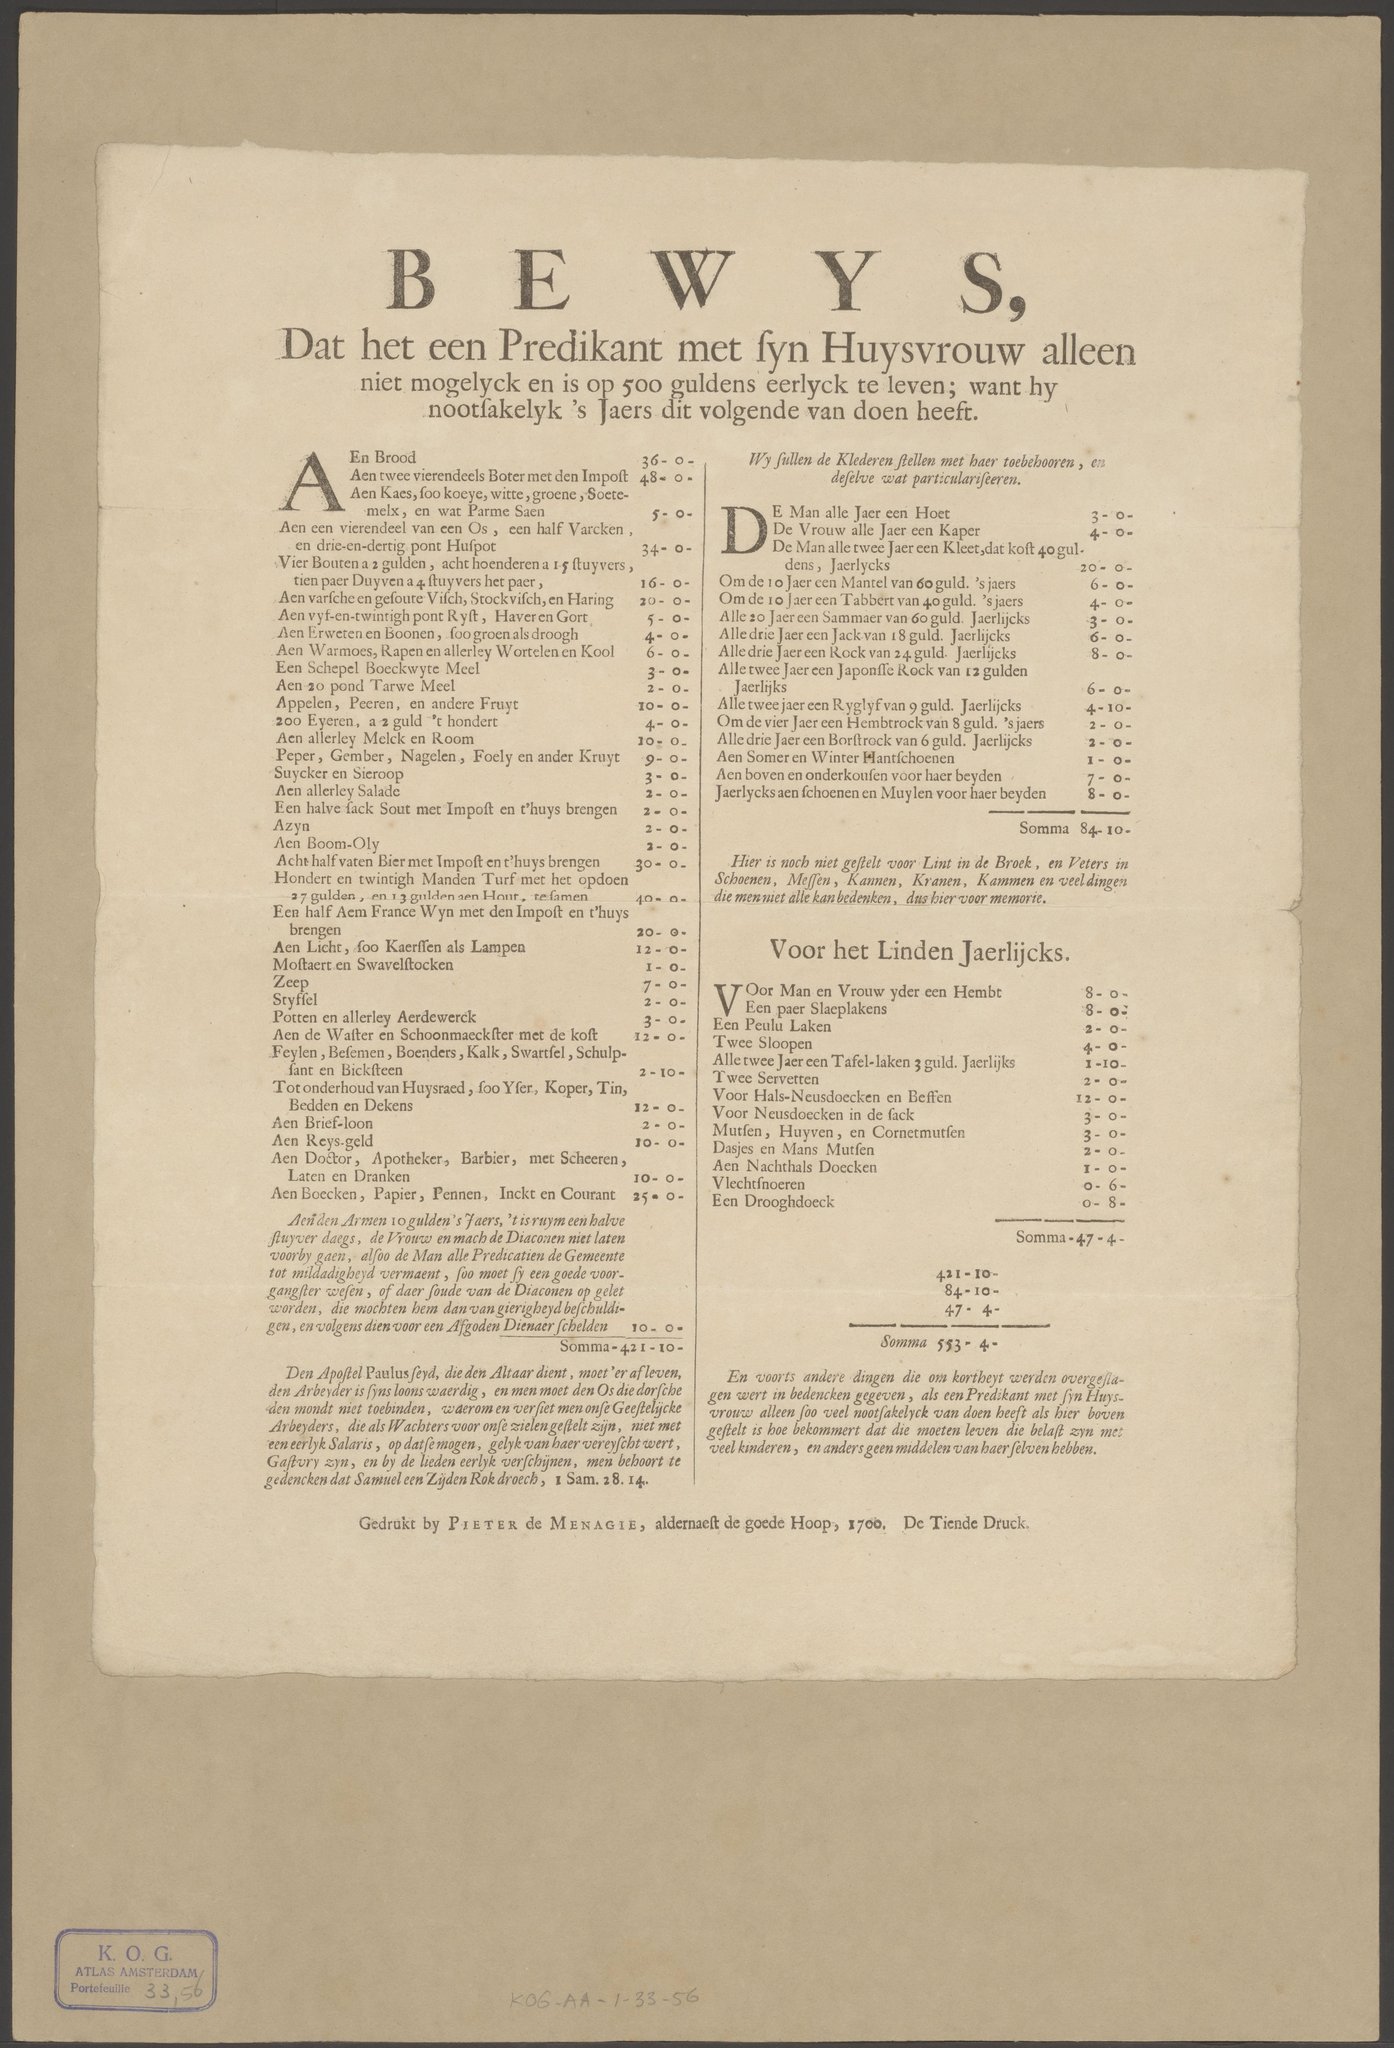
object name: text sheet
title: Lijst met jaarkosten van een predikant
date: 1700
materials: paper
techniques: letterpress printing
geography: northern netherlands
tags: protestant churches and denominations, preaching (in general)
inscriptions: collector's mark: Lugt 1641b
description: Onderwerpsrubriek binnen de Atlas Amsterdam: Kerkwezen: Hervormde Gemeente: Herinneringen aan hervormde predikanten.